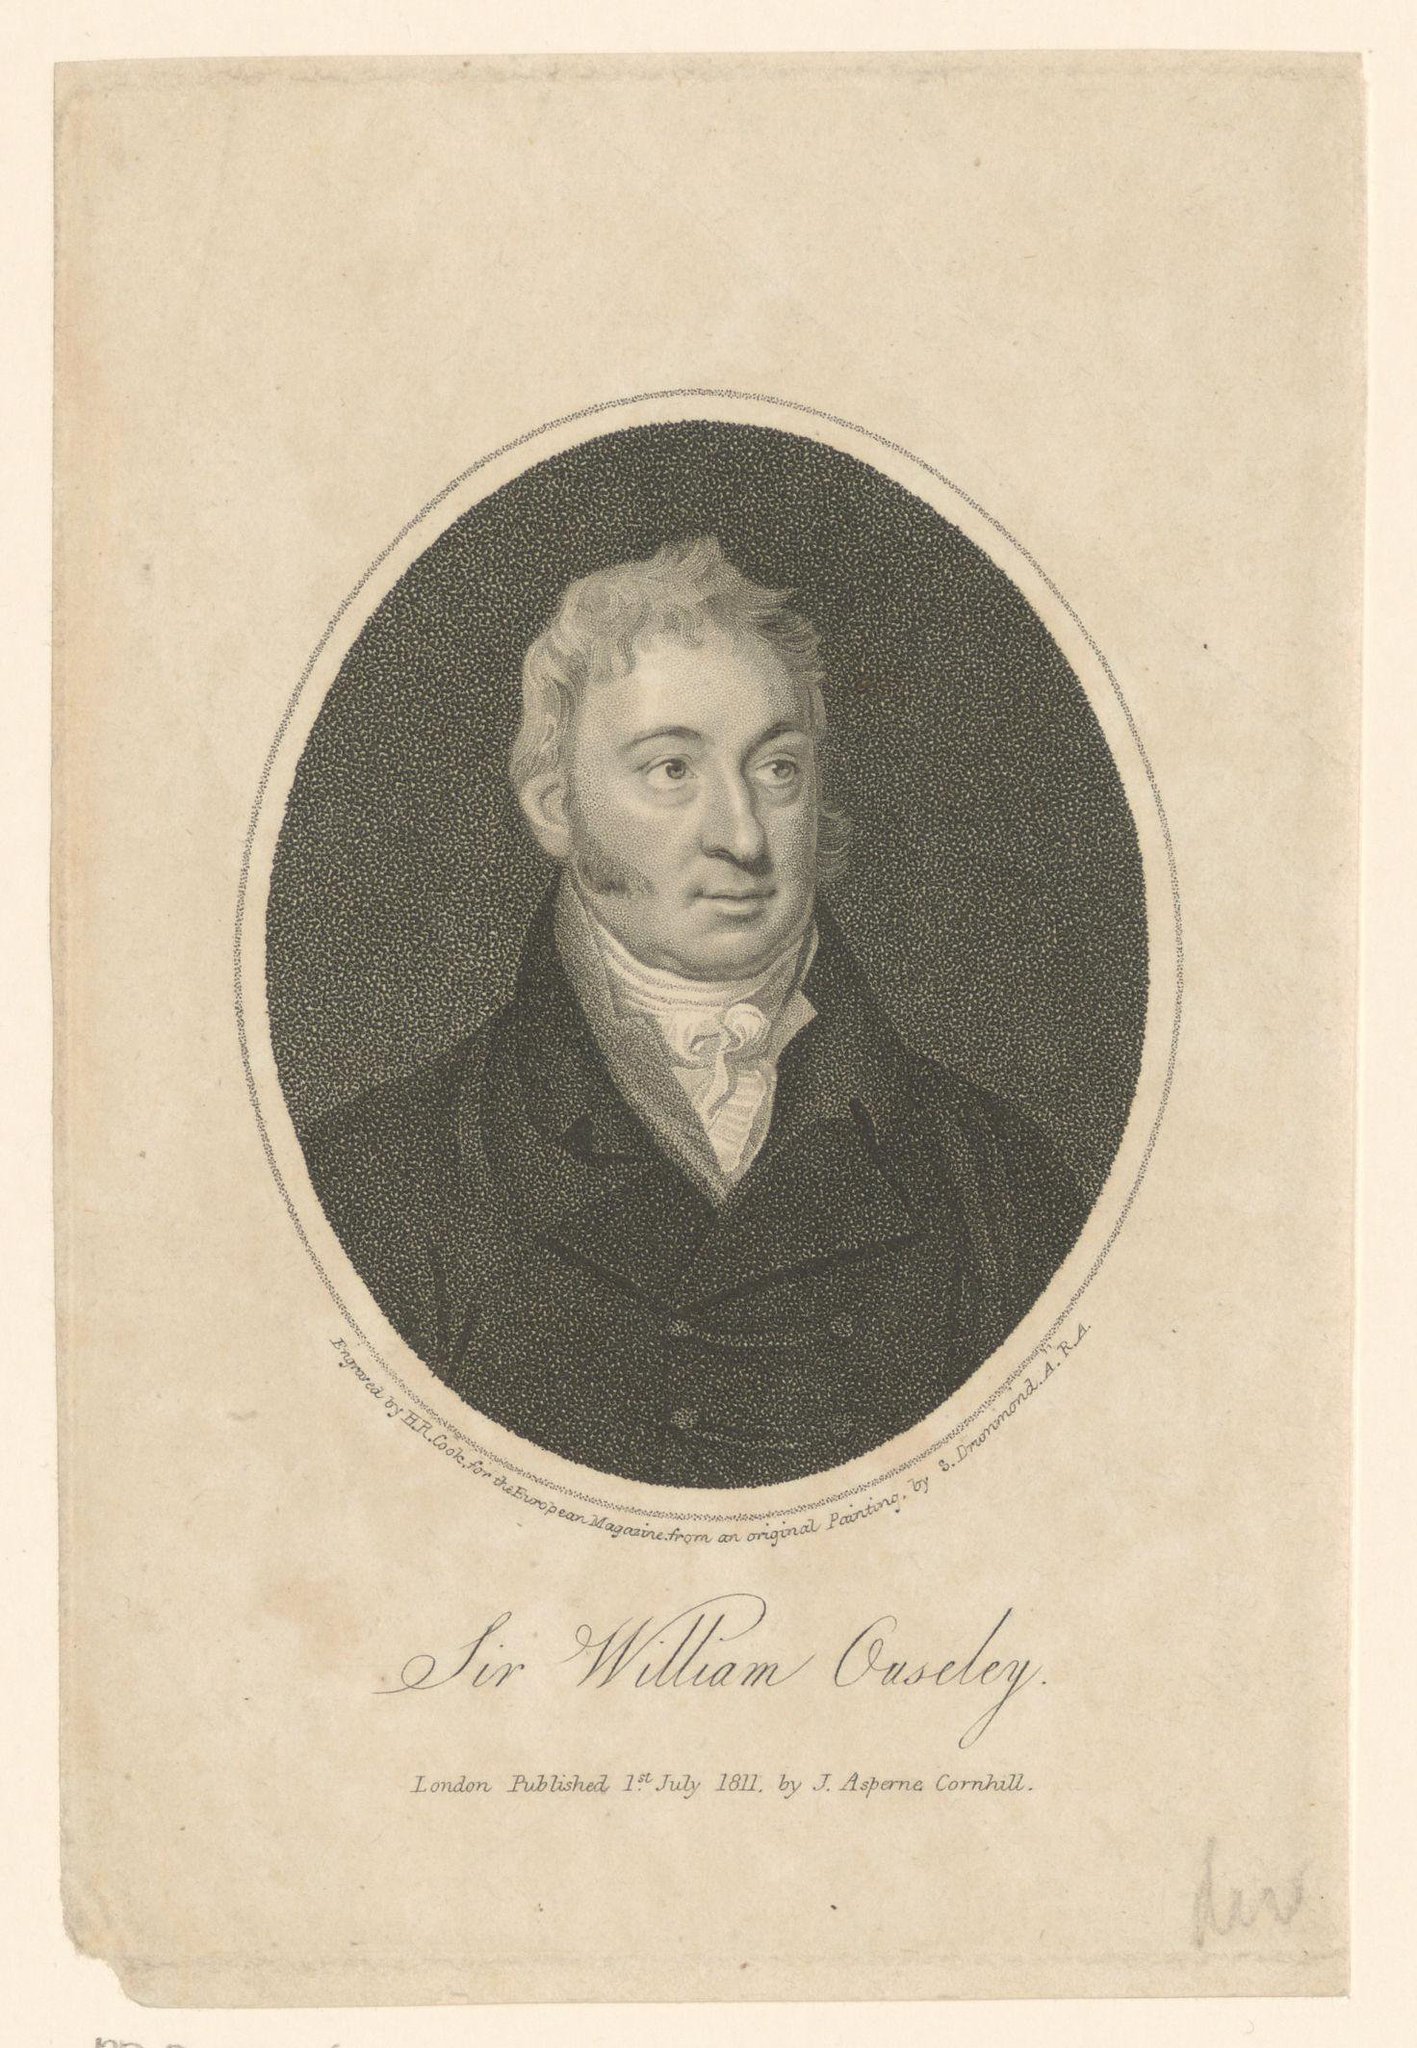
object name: print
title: Portret van William Ouseley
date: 1811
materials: paper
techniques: stippling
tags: history and archaeology (+ portrait of scholar, scientist), historical persons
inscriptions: collector's mark: Lugt 2228